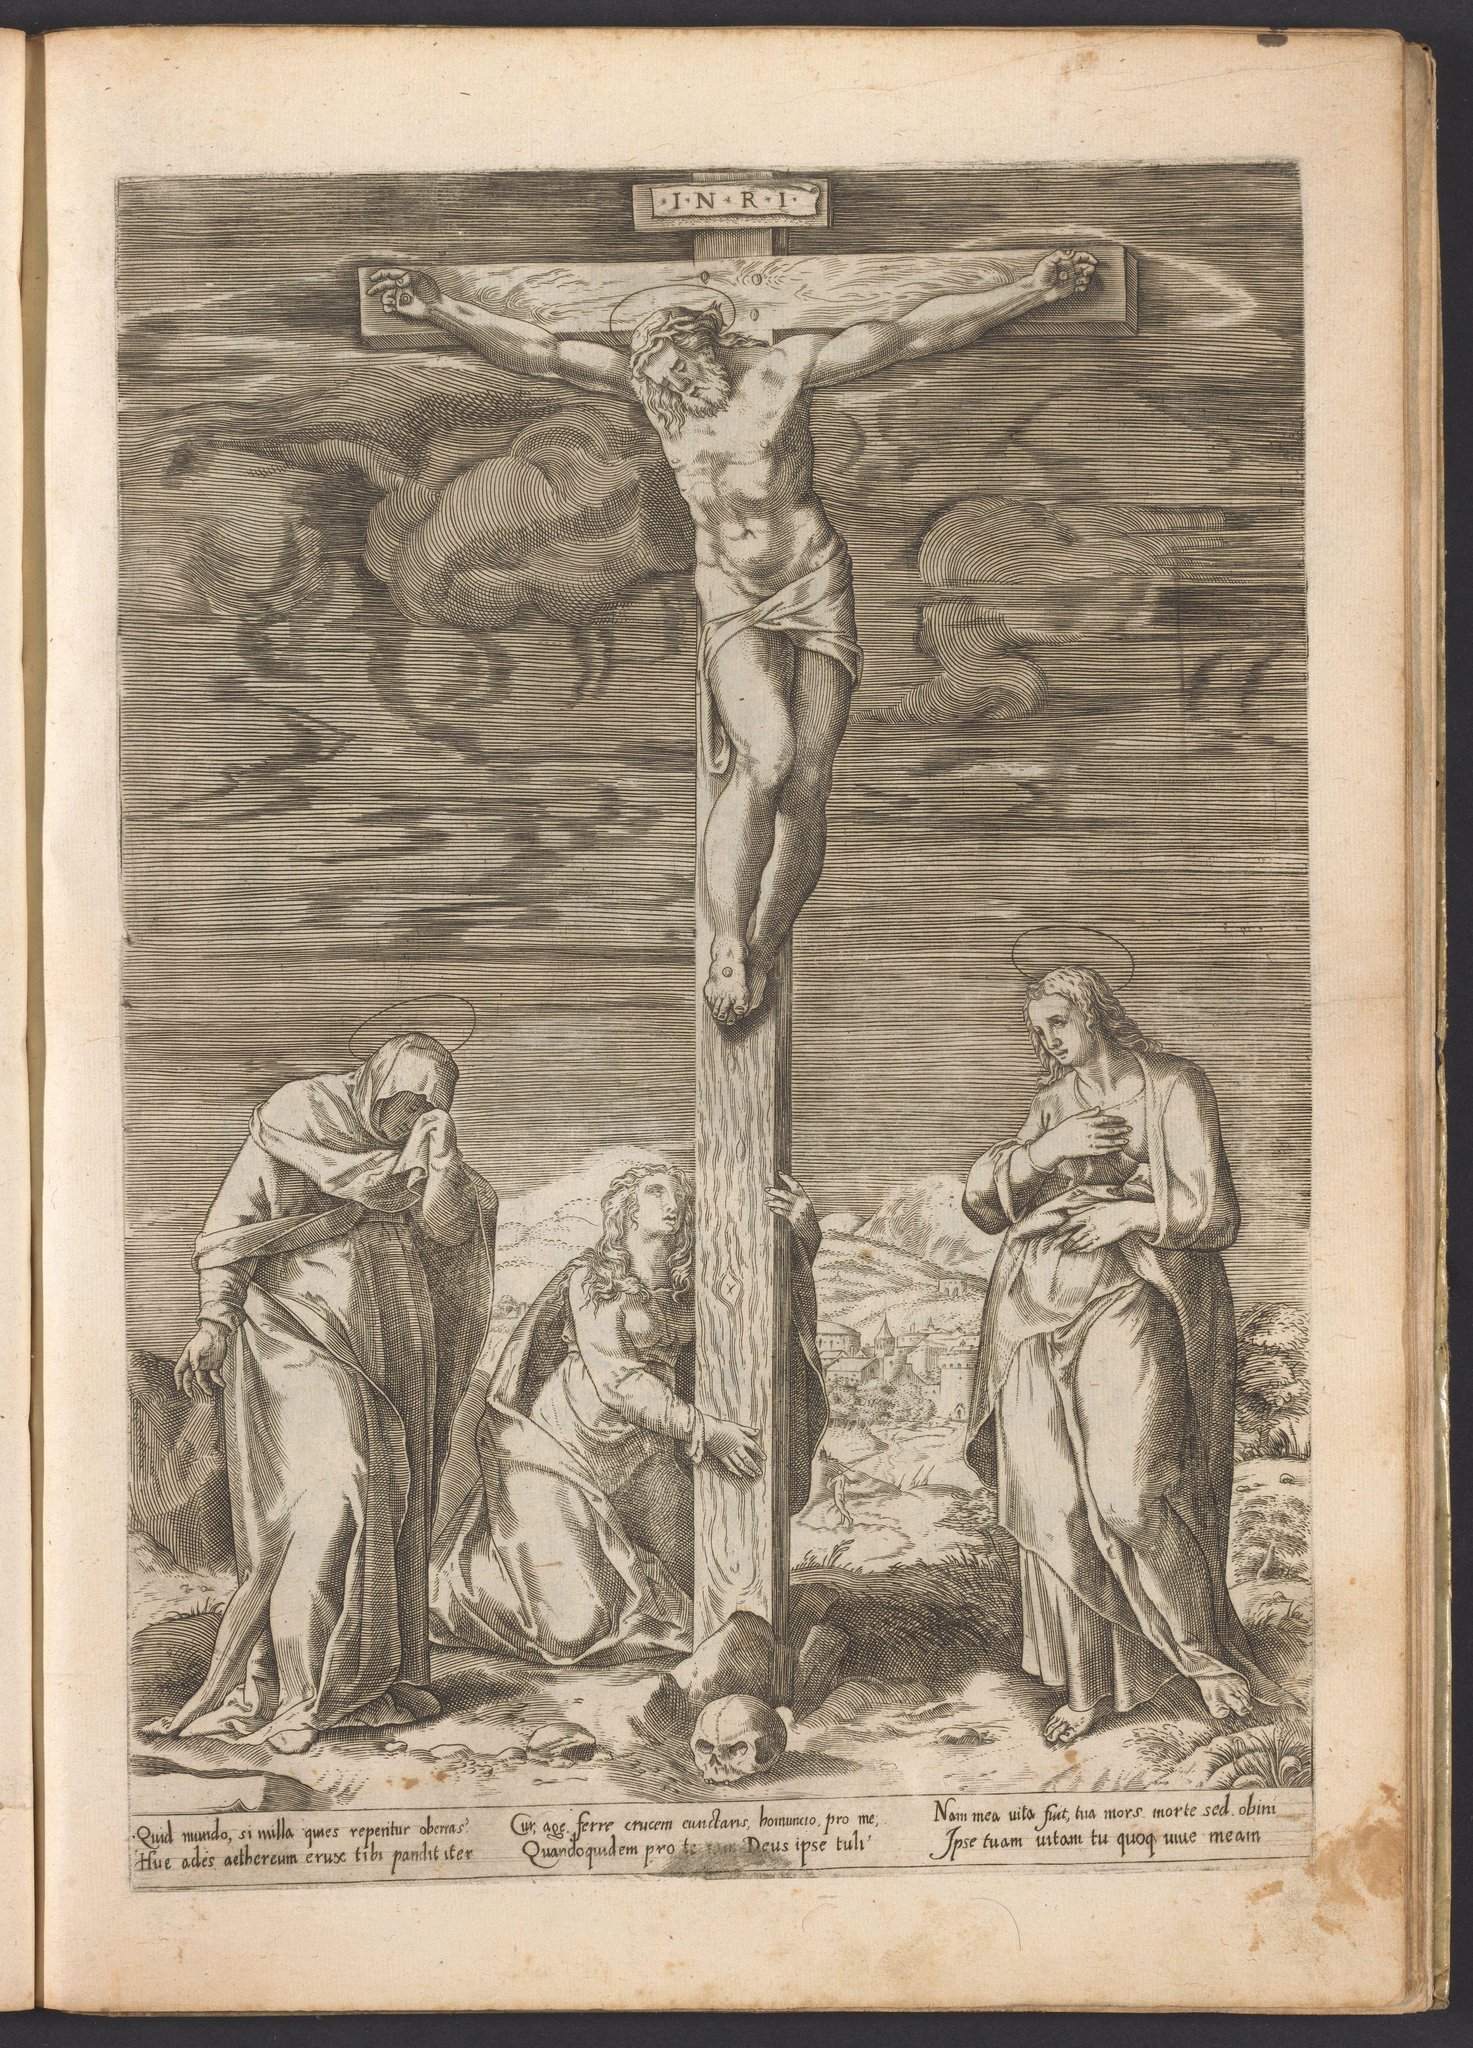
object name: album leaf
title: Kruisiging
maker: Anonymous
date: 1570-1573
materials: paper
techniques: engraving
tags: crucified christ, with particular persons under the cross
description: Deze prent maakt deel uit van een album.